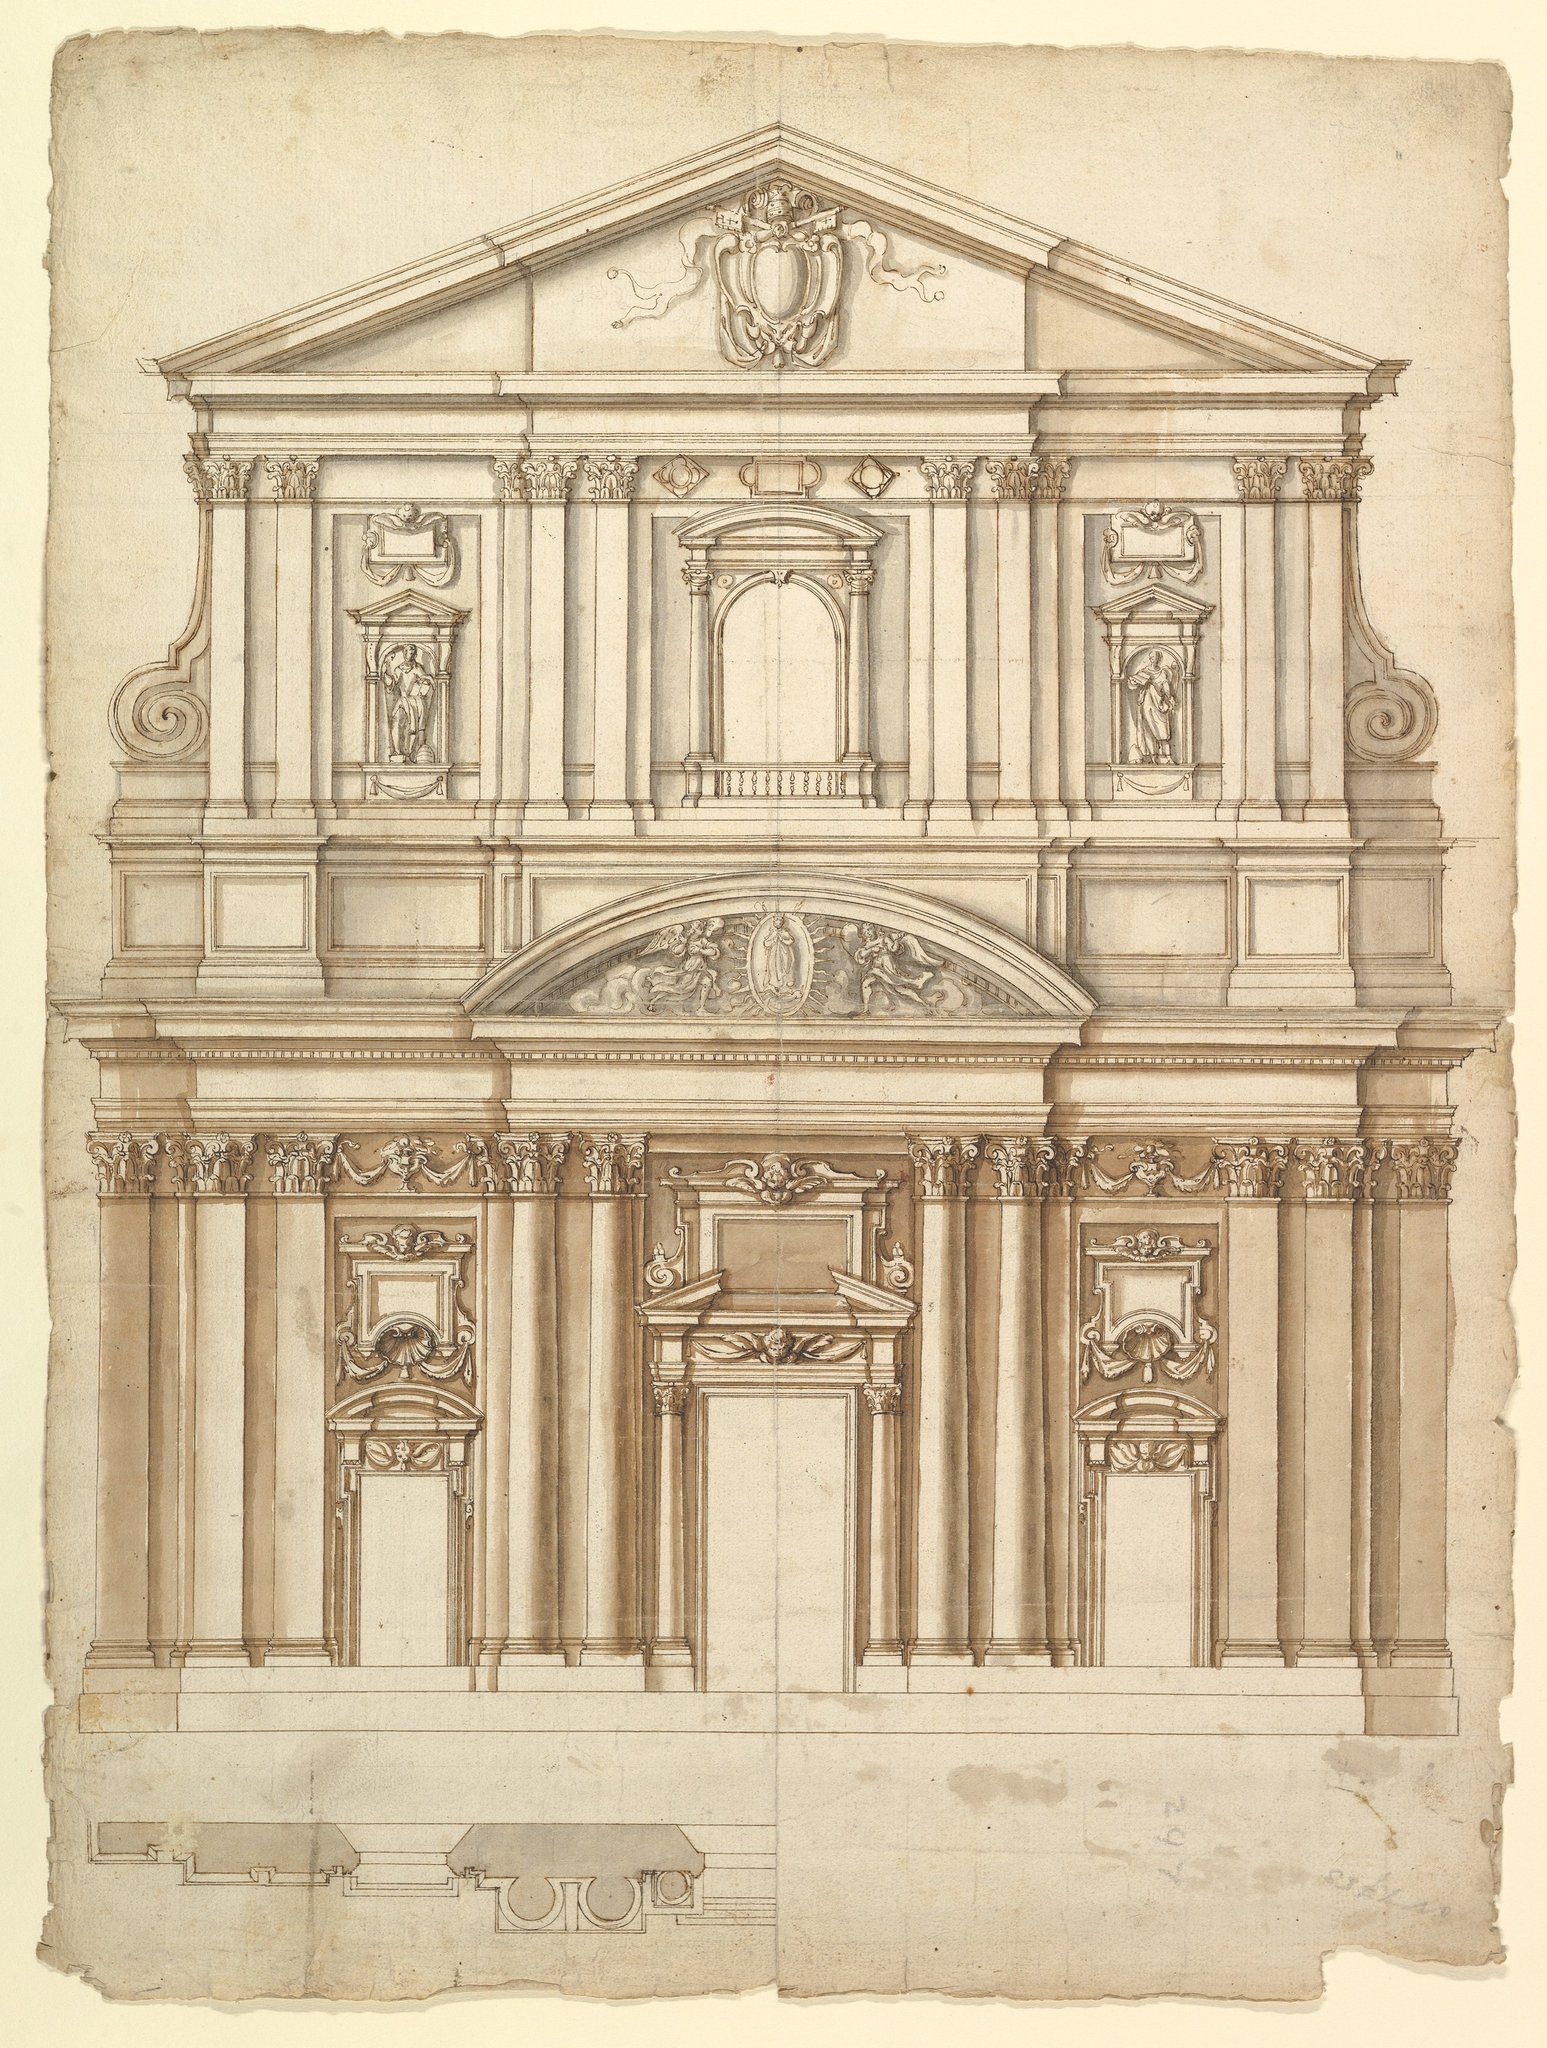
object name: drawing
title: Santa Maria in Vallicella, elevation; plan (recto) blank (verso)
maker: anonymous, french, 16th century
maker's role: draftsman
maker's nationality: french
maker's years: 1500-1600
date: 1567-1600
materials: chalk, ink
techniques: incising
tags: architecture